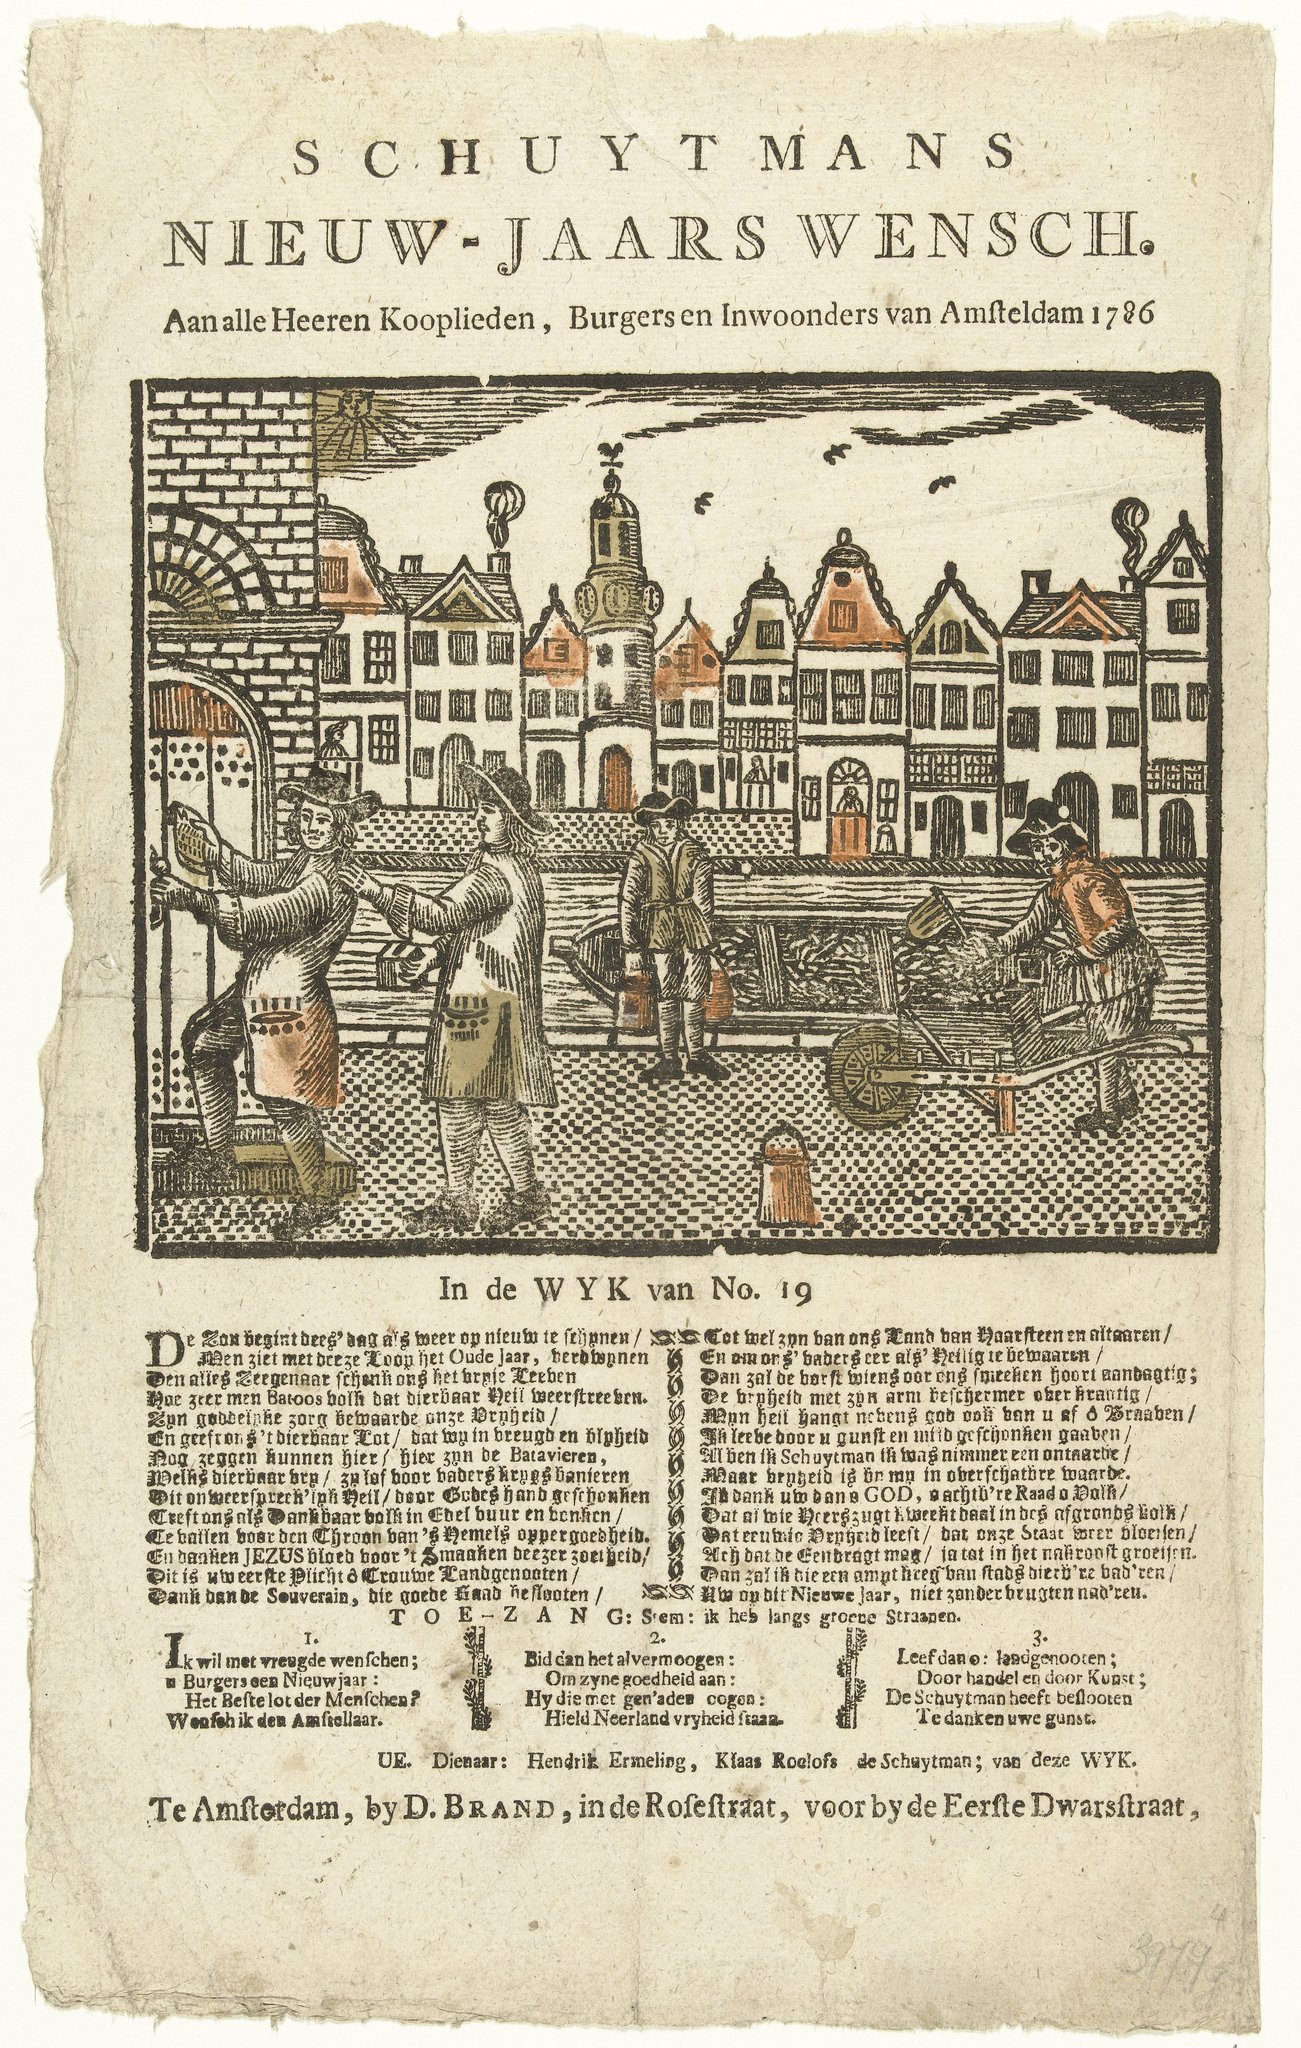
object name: print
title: Schuytmans Nieuw-Jaars Wensch. Aan alle Heeren Kooplieden, Burgers en Inwoonders van Amsteldam 1786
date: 1785-1786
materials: paper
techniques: hand coloring, letterpress printing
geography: amsterdam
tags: garbage collection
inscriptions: collector's mark: Lugt 2228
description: Nieuwjaarsprent voor het jaar 1786 van Klaas Roelofs, de schuitman in de wijk 19, opgedragen aan de burgers van Amsterdam. Man met kruiwagen en ratel en een man bij een schuit in de gracht. Op het blad onder de voorstelling een vers in twee kolommen met in de toezang een lied in drie kolommen.